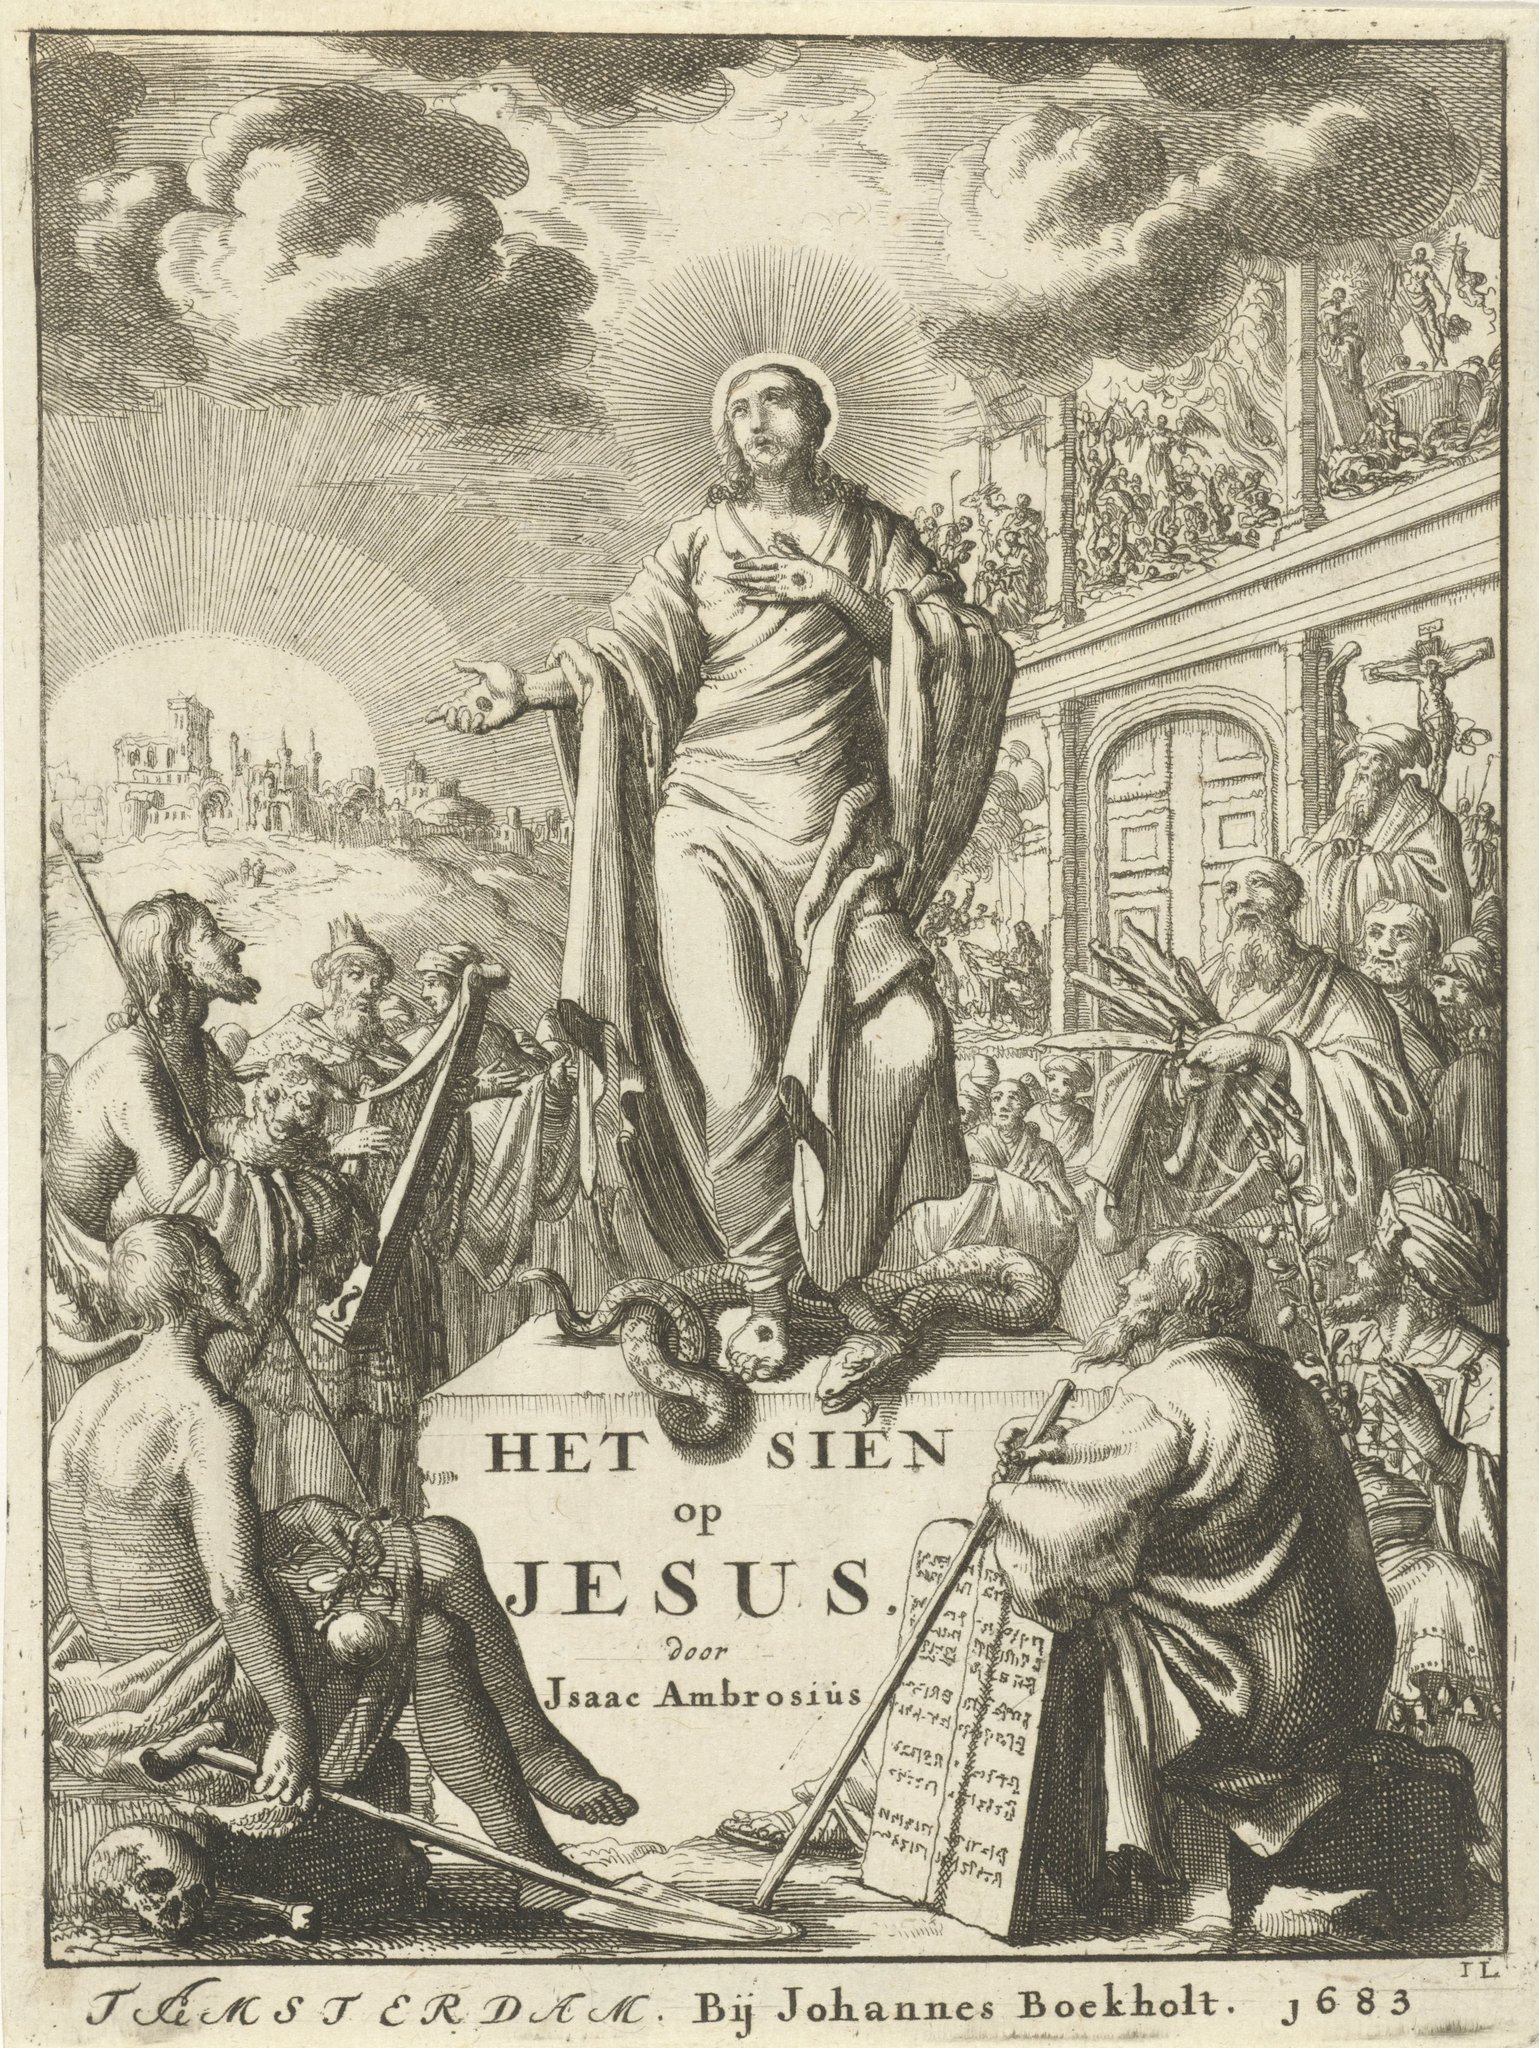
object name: titelblad, titelpagina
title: Christus omringd door geloofshelden uit het Oude Verbond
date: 1683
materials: paper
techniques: etching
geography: amsterdam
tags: christ as adult, groups of persons from the old testament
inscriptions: collector's mark: Lugt 240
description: Titelpagina voor: Ambrose, Isaac. Het sien op Jesus: een gesicht des eeuwigen euangeliums. Amsterdam: Johannes Boekholt, 1683. Dezelfde plaat is later gebruikt in: Hessen, Willem. 't Lyden en sterven van Jezus Christus. In XII. boeken. Haarlem: Mozes van Hulkenroy, 1733. Tevens in de tweede druk door Bernardus van der Cloese, 1738 te Den Haag.